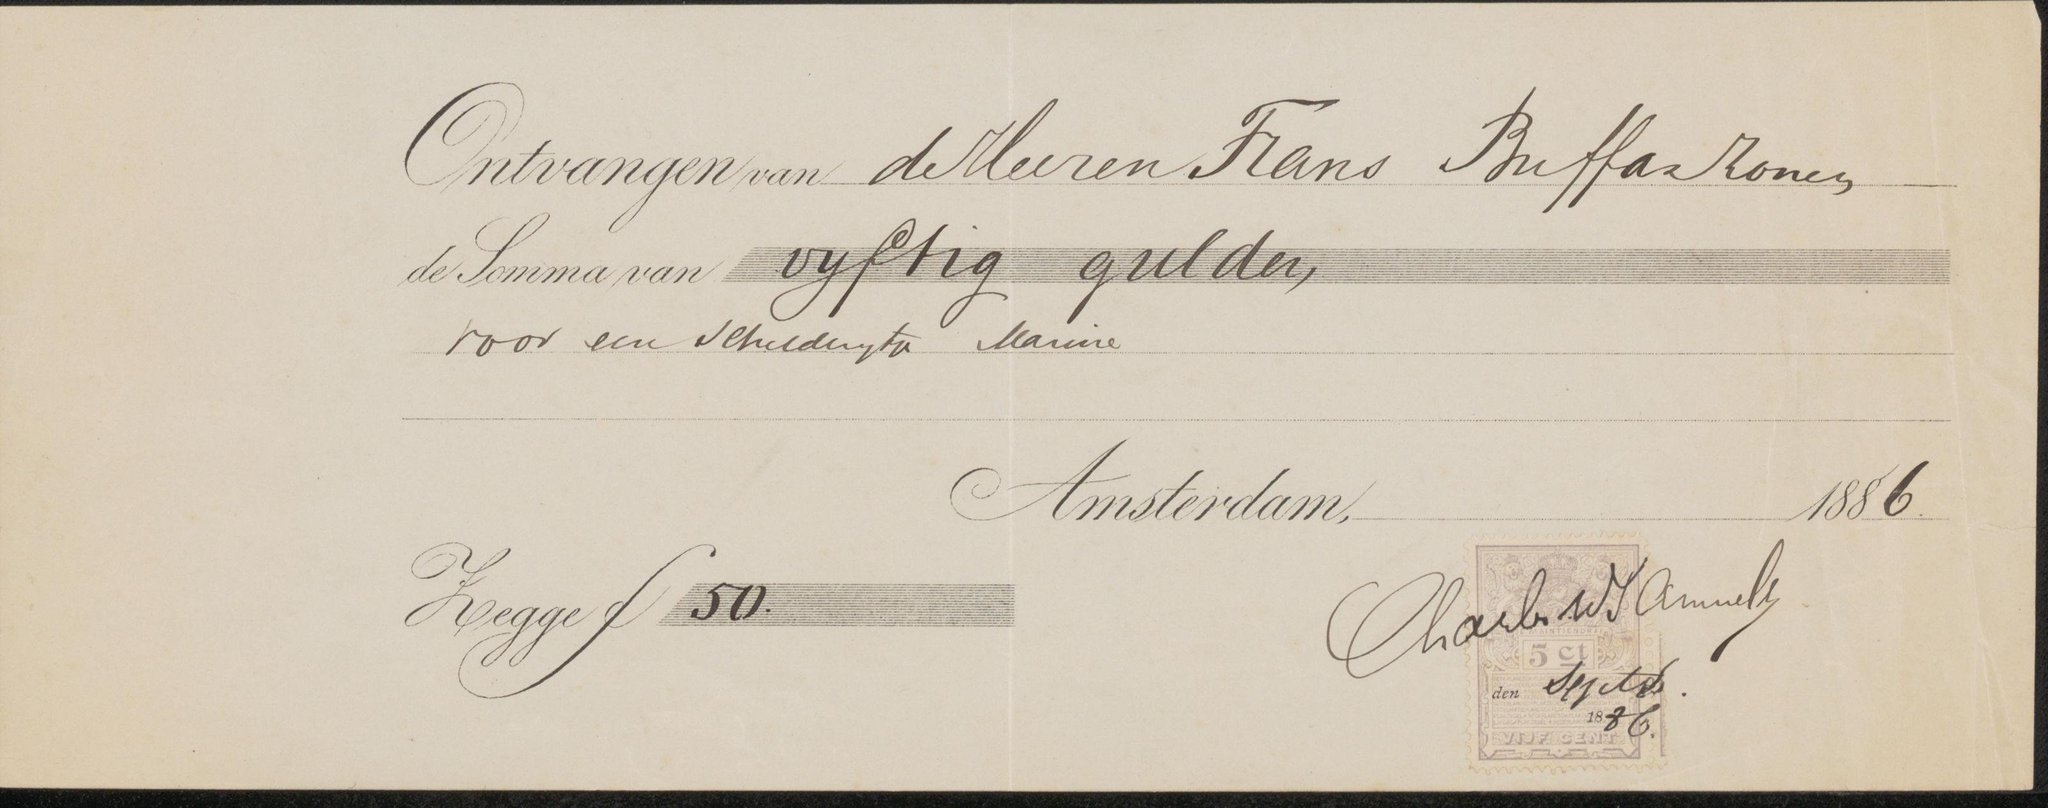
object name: ontvangstbewijs, kwitantie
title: Kwitantie voor Charles Samuel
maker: charles samuel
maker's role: sculptor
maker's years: 1862-1938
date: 1809-1886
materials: ink, paper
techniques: pen, printing, writing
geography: amsterdam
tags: painting (including book-illumination, miniature-painting), money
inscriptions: collector's mark: Lugt 2233